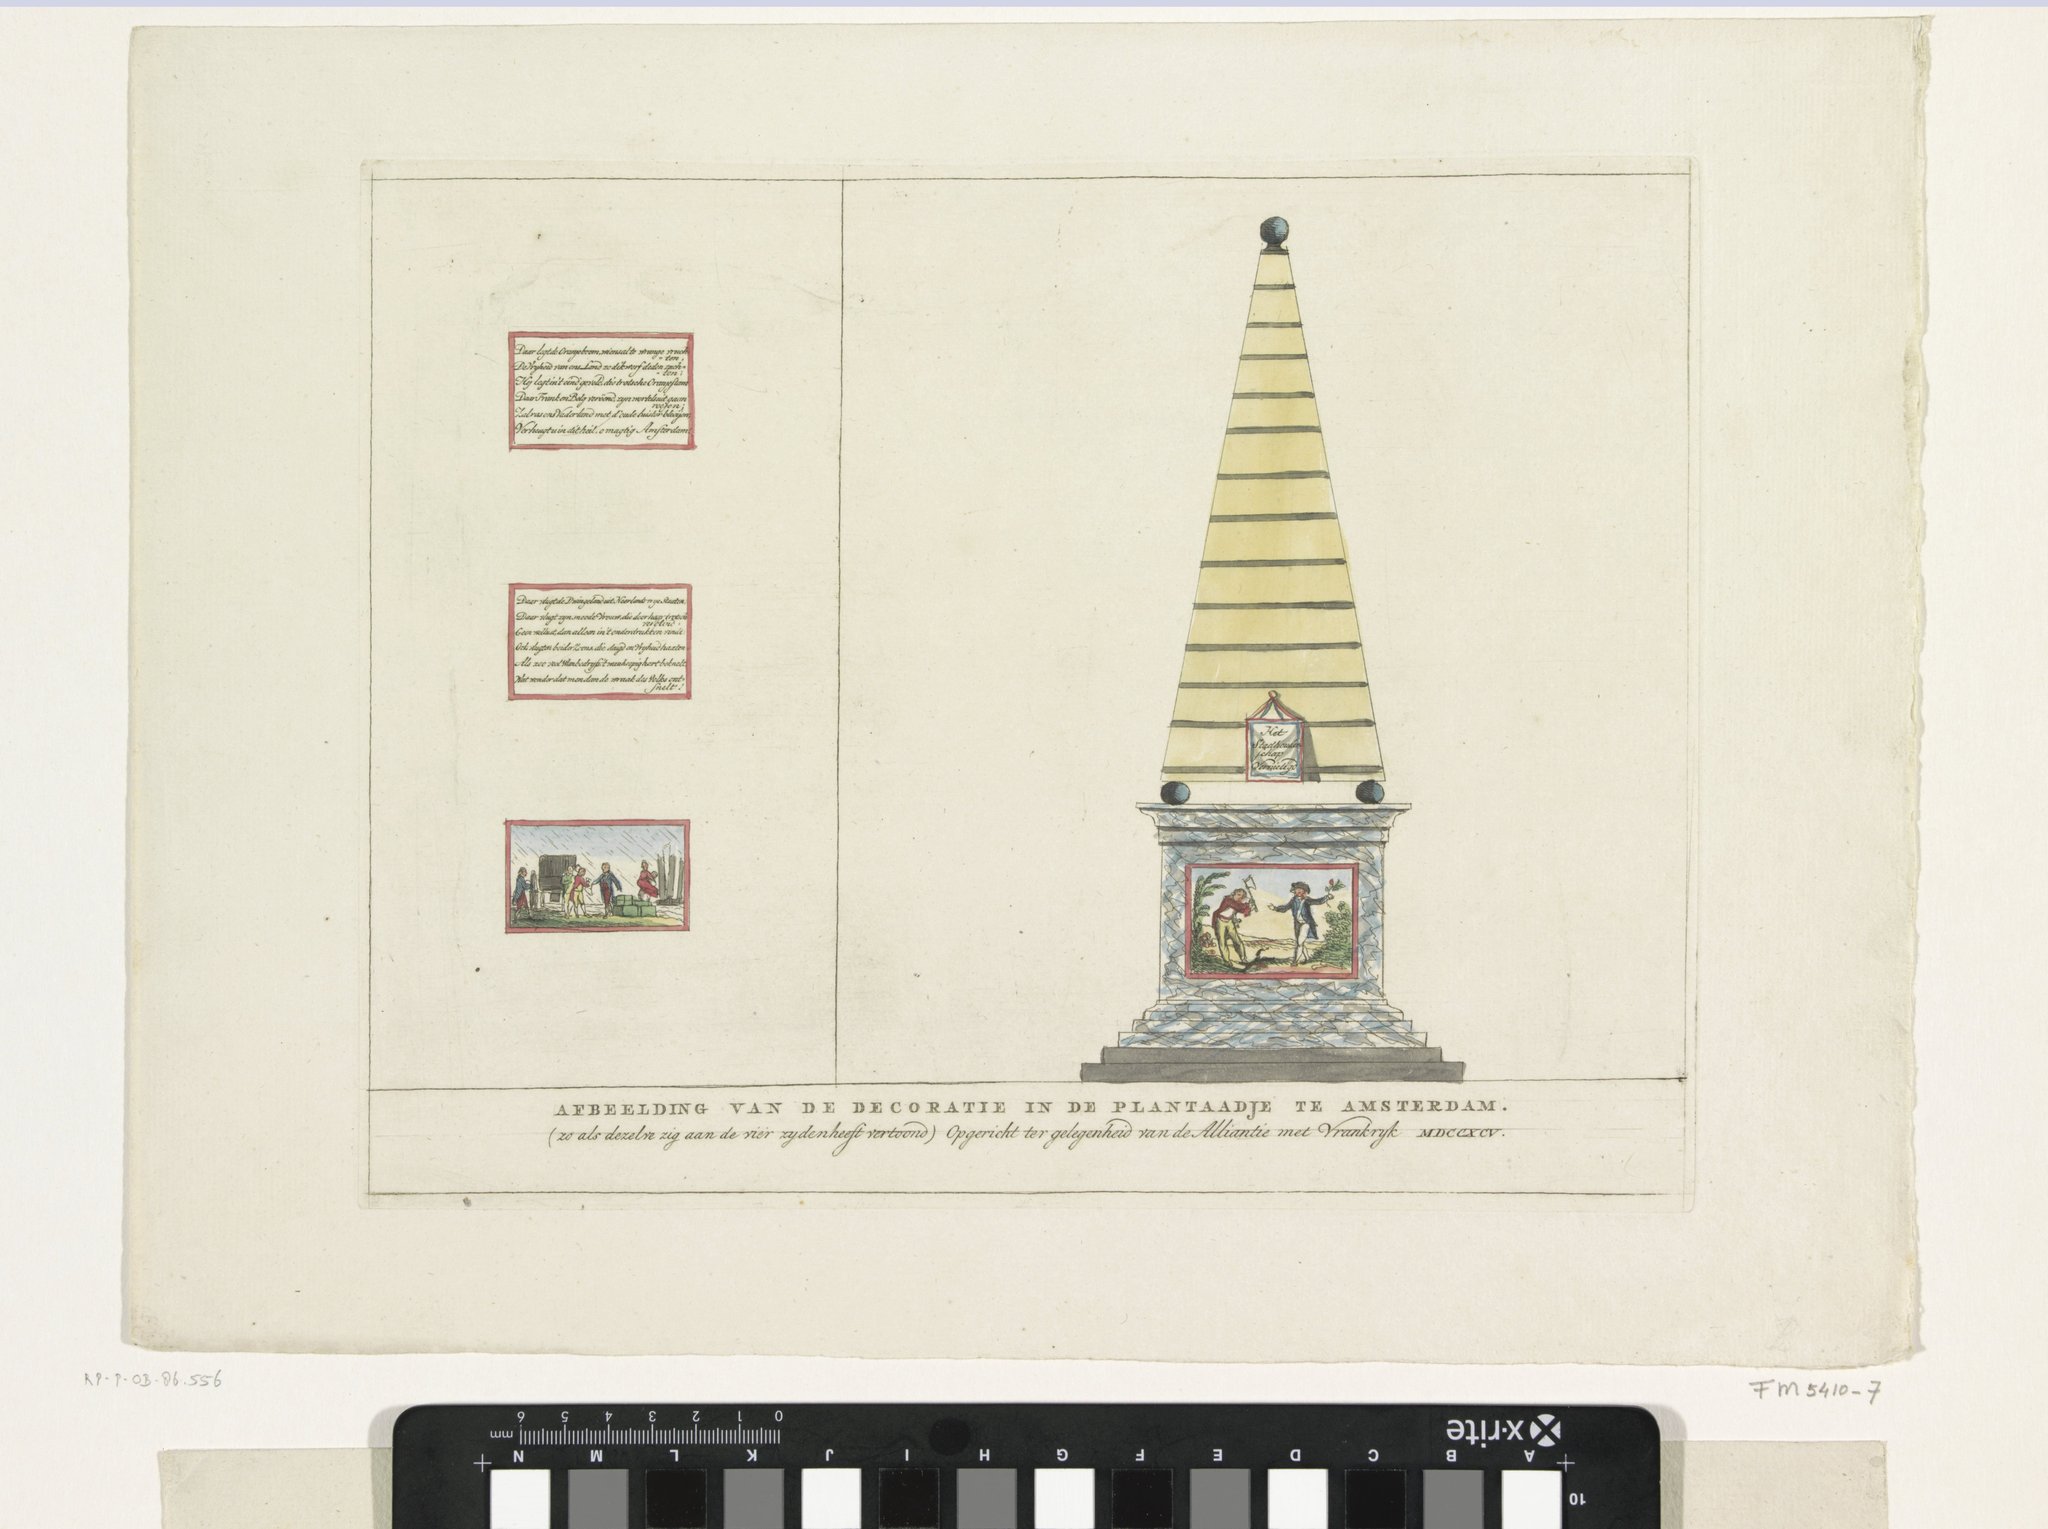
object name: print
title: Afbeelding van de Decoratie in de Plantaadje te Amsterdam. (zo als dezelve zig aan de vier zijden heeft vertoond) Opgericht ter gelegenheid van de Alliantie met Vrankryk MDCCXCV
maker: Anonymous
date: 1795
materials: paper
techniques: etching, hand coloring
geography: netherlands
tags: woodcutting, woodcutter ~ forestry, festivities on events of national importance (+ festive decoration ~ festive activities), amsterdam, alliance with france (1795)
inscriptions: collector's mark: Lugt 2228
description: Decoratie opgericht in de Plantage te Amsterdam bij het Alliantiefeest op 19 juni 1795. Piramide op een voetsuk met een chassinet waarop een allegorische voorstelling van de vernietiging van het stadhouderschap als een Bataaf en een Fransman die de Oranjeboom omhakken en van de de vlucht van prins Willem V vanuit Scheveningen op 18 januari 1795. Onderdeel van een serie van tien platen.